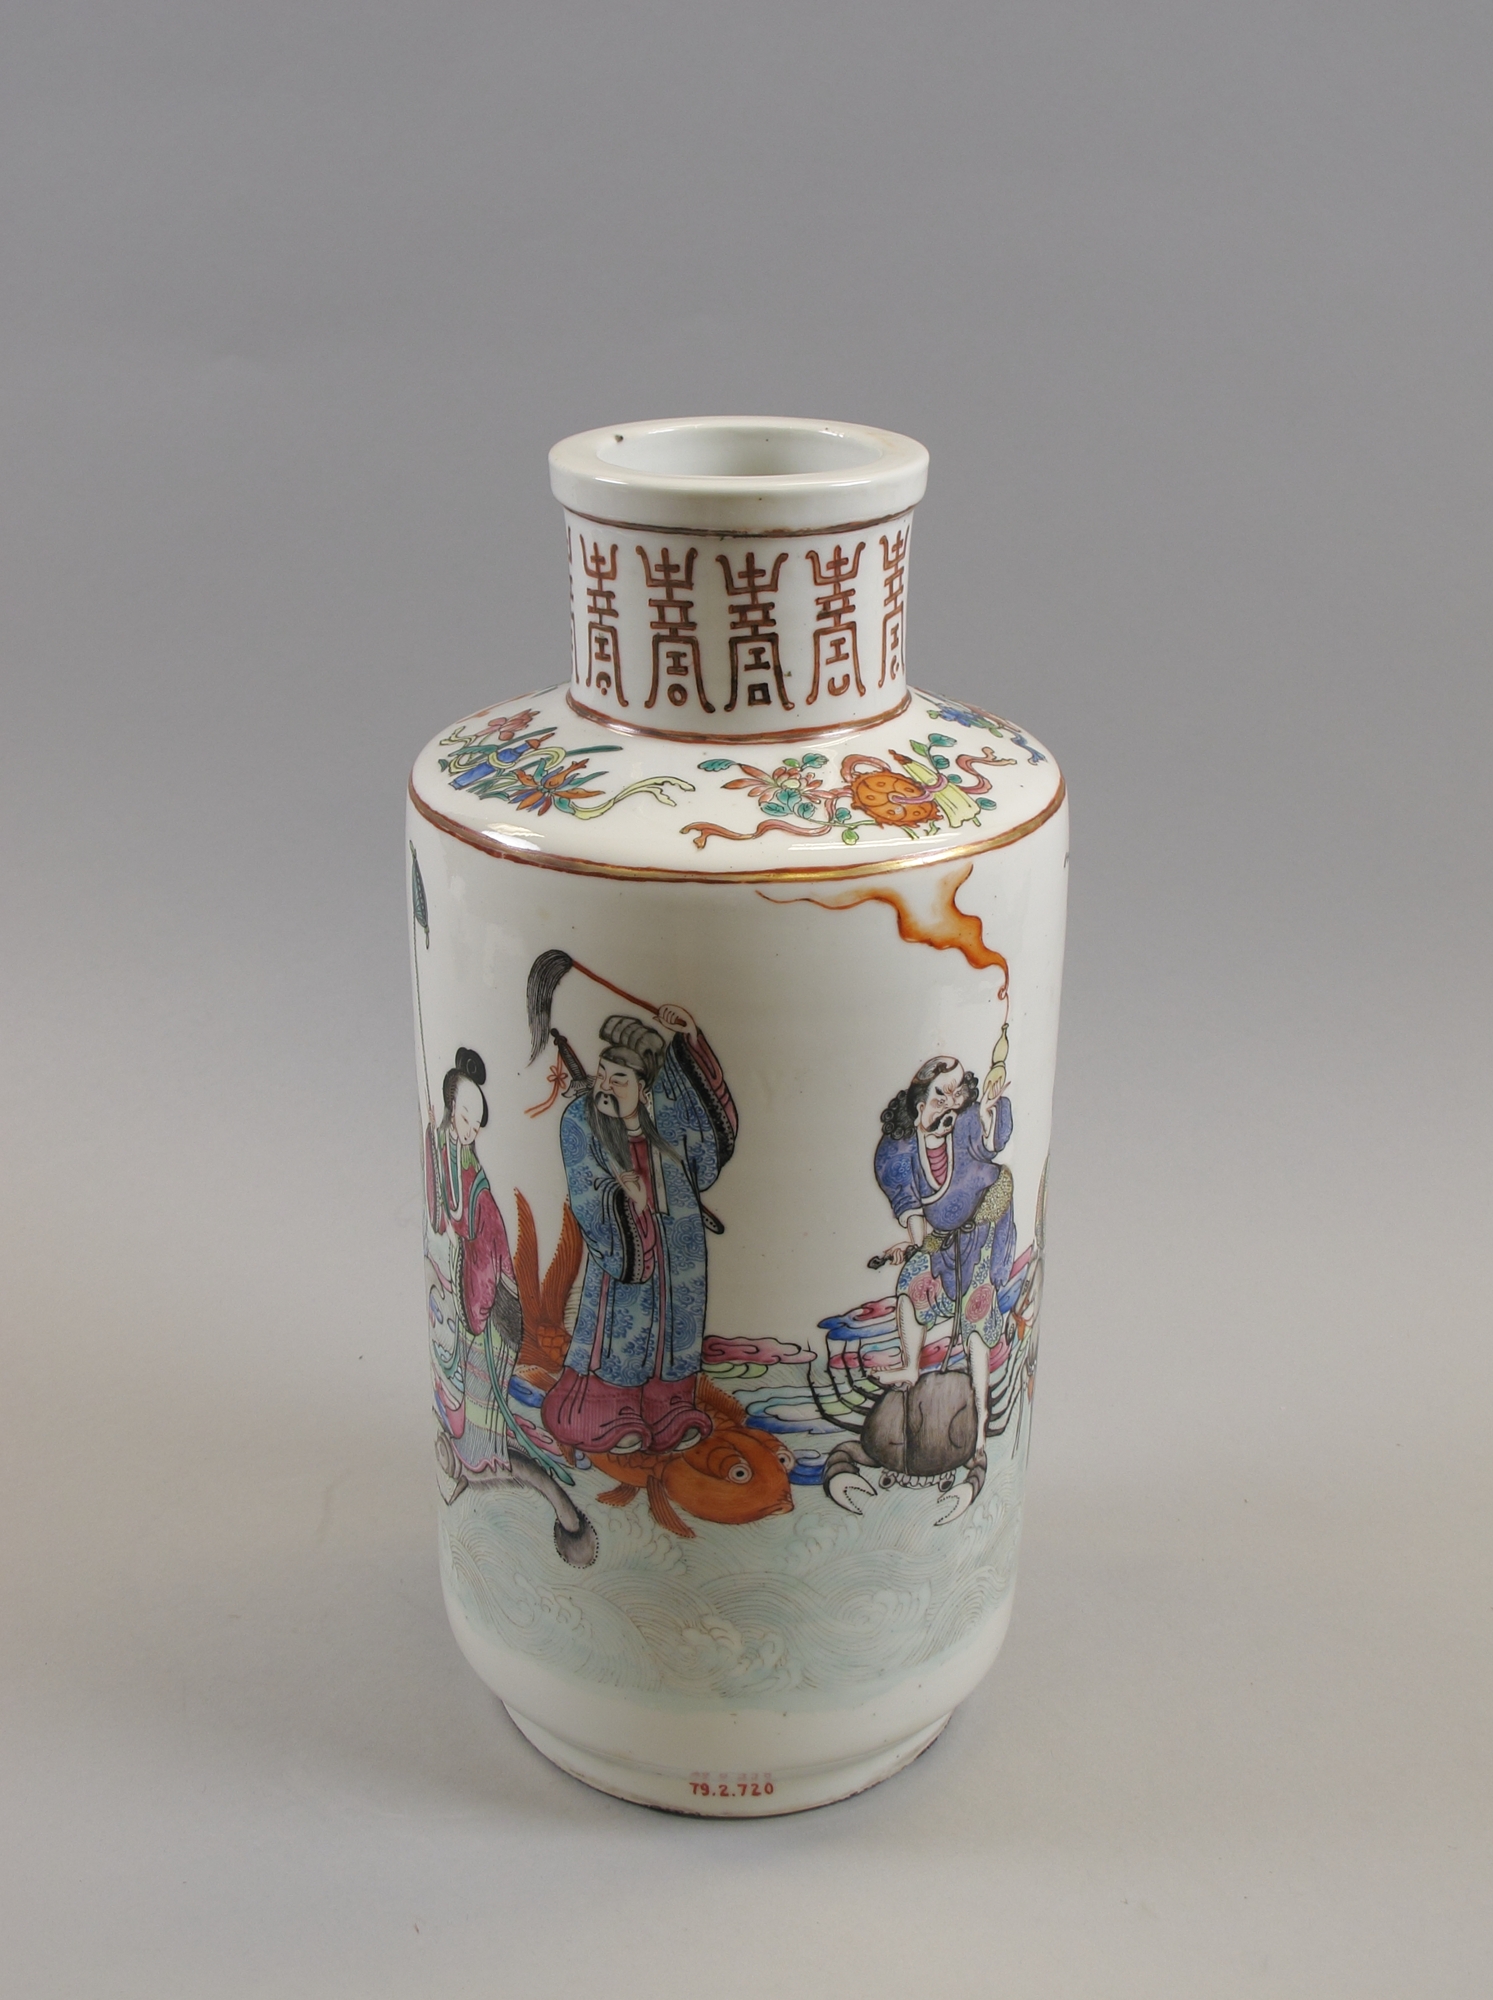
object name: vase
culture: chinese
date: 1801-1850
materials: enamel, gilt, porcelain, silver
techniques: overglaze, painting, polychrome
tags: men,women,flowers